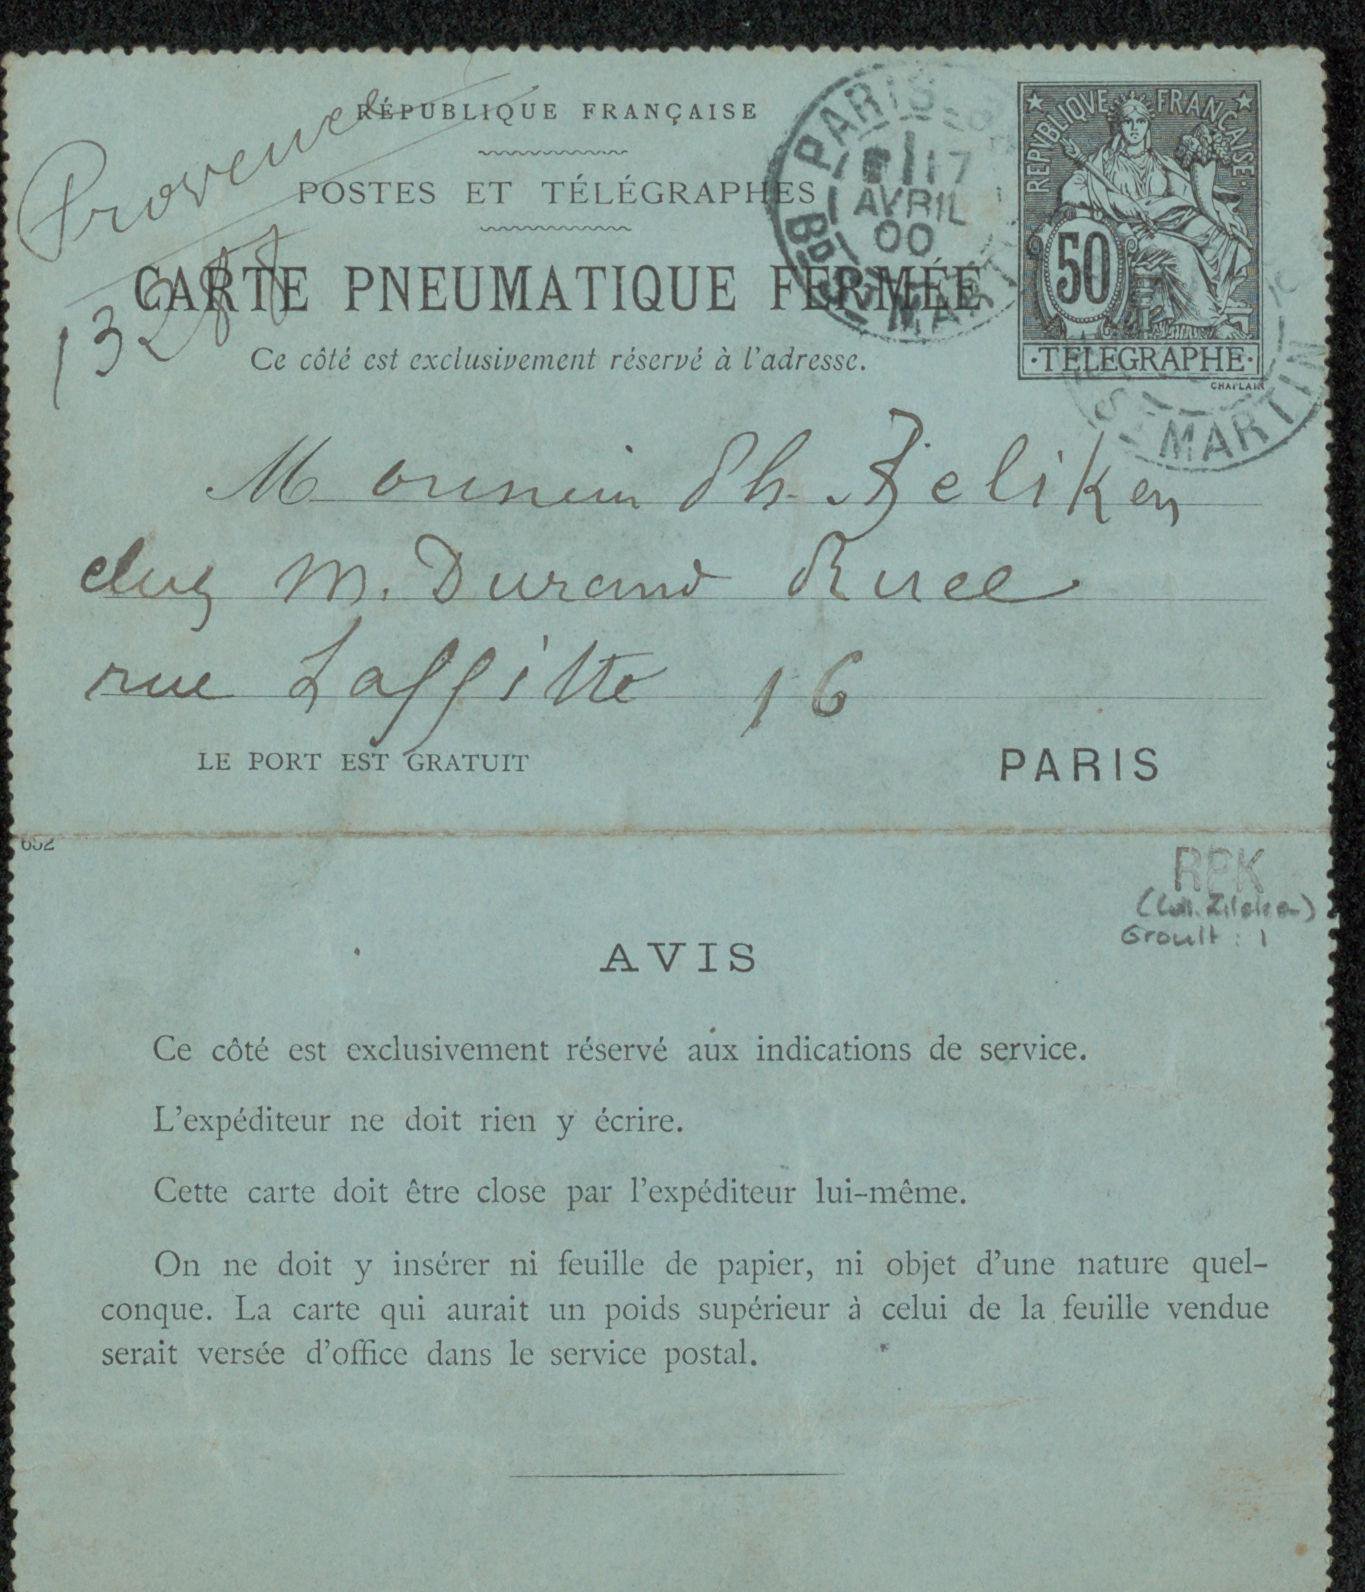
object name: postcard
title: Briefkaart aan Philip Zilcken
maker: groult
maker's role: schrijver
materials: cardboard, ink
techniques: pen, writing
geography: paris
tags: the hague, draughtsman, philip zilcken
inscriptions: collector's mark: ‘RPK’